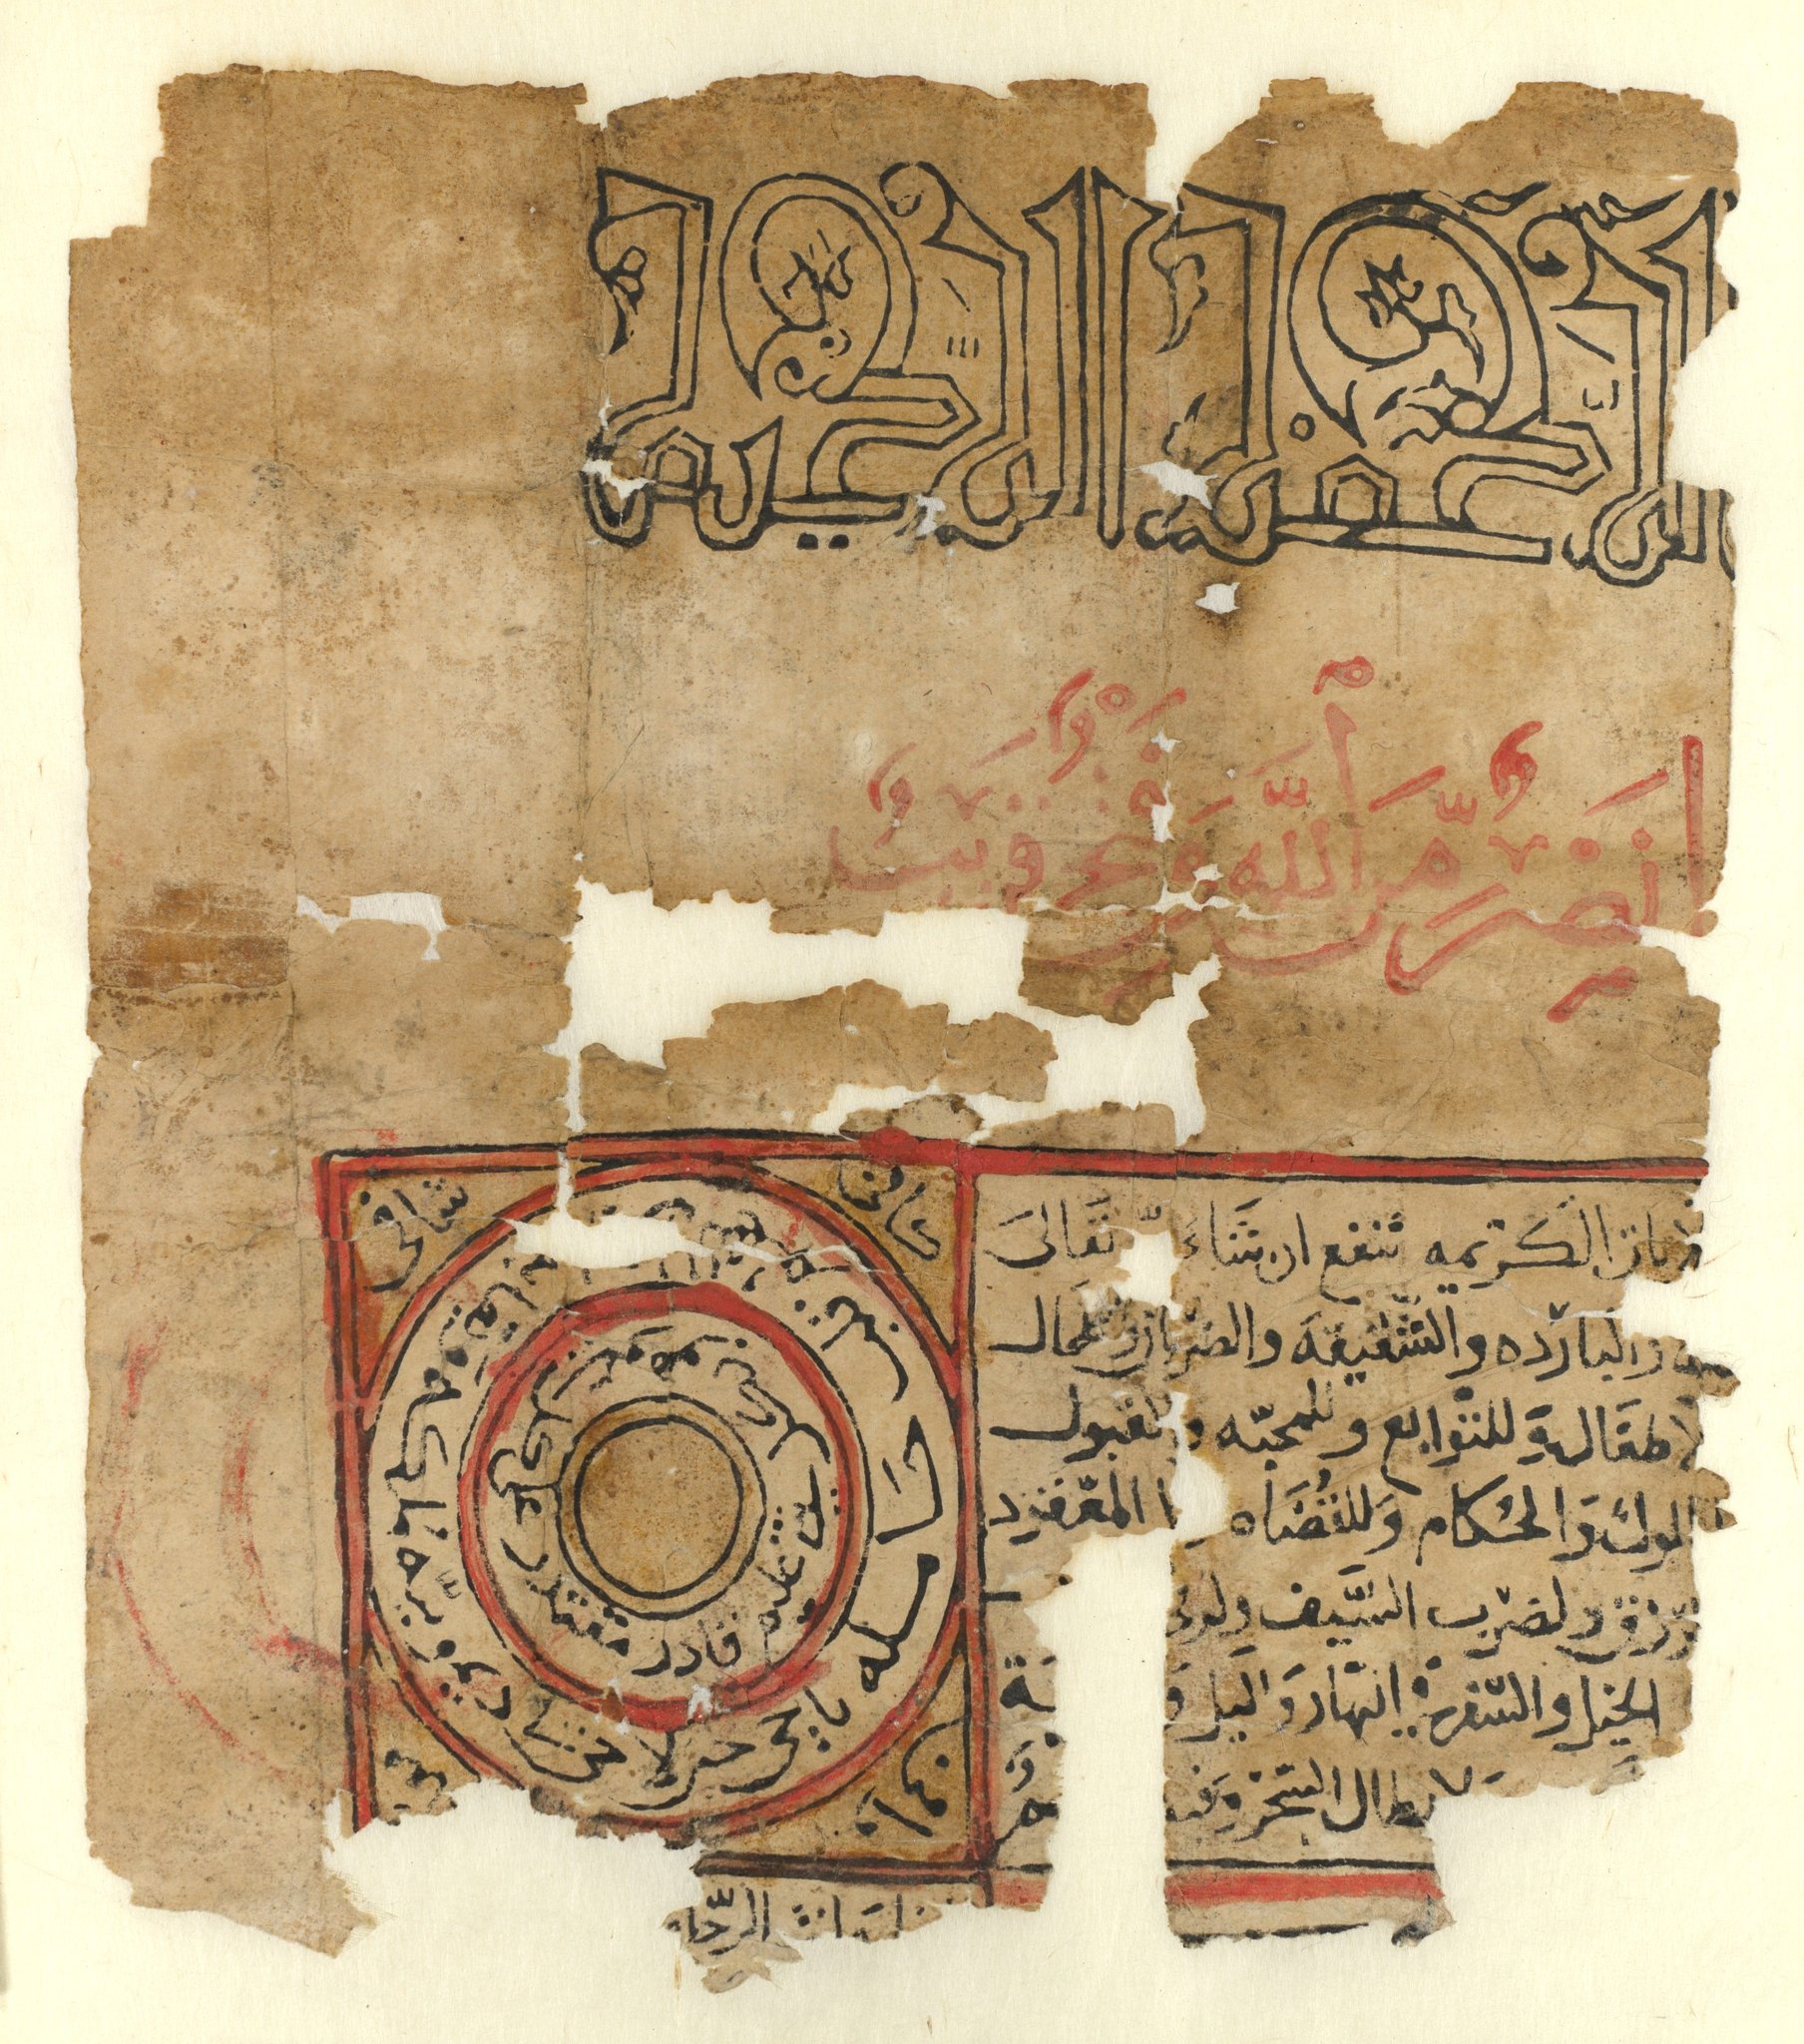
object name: scroll fragment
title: Fragment from a Talismanic Scroll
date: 1001-1200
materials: ink, paper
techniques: printing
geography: egypt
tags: scrolls